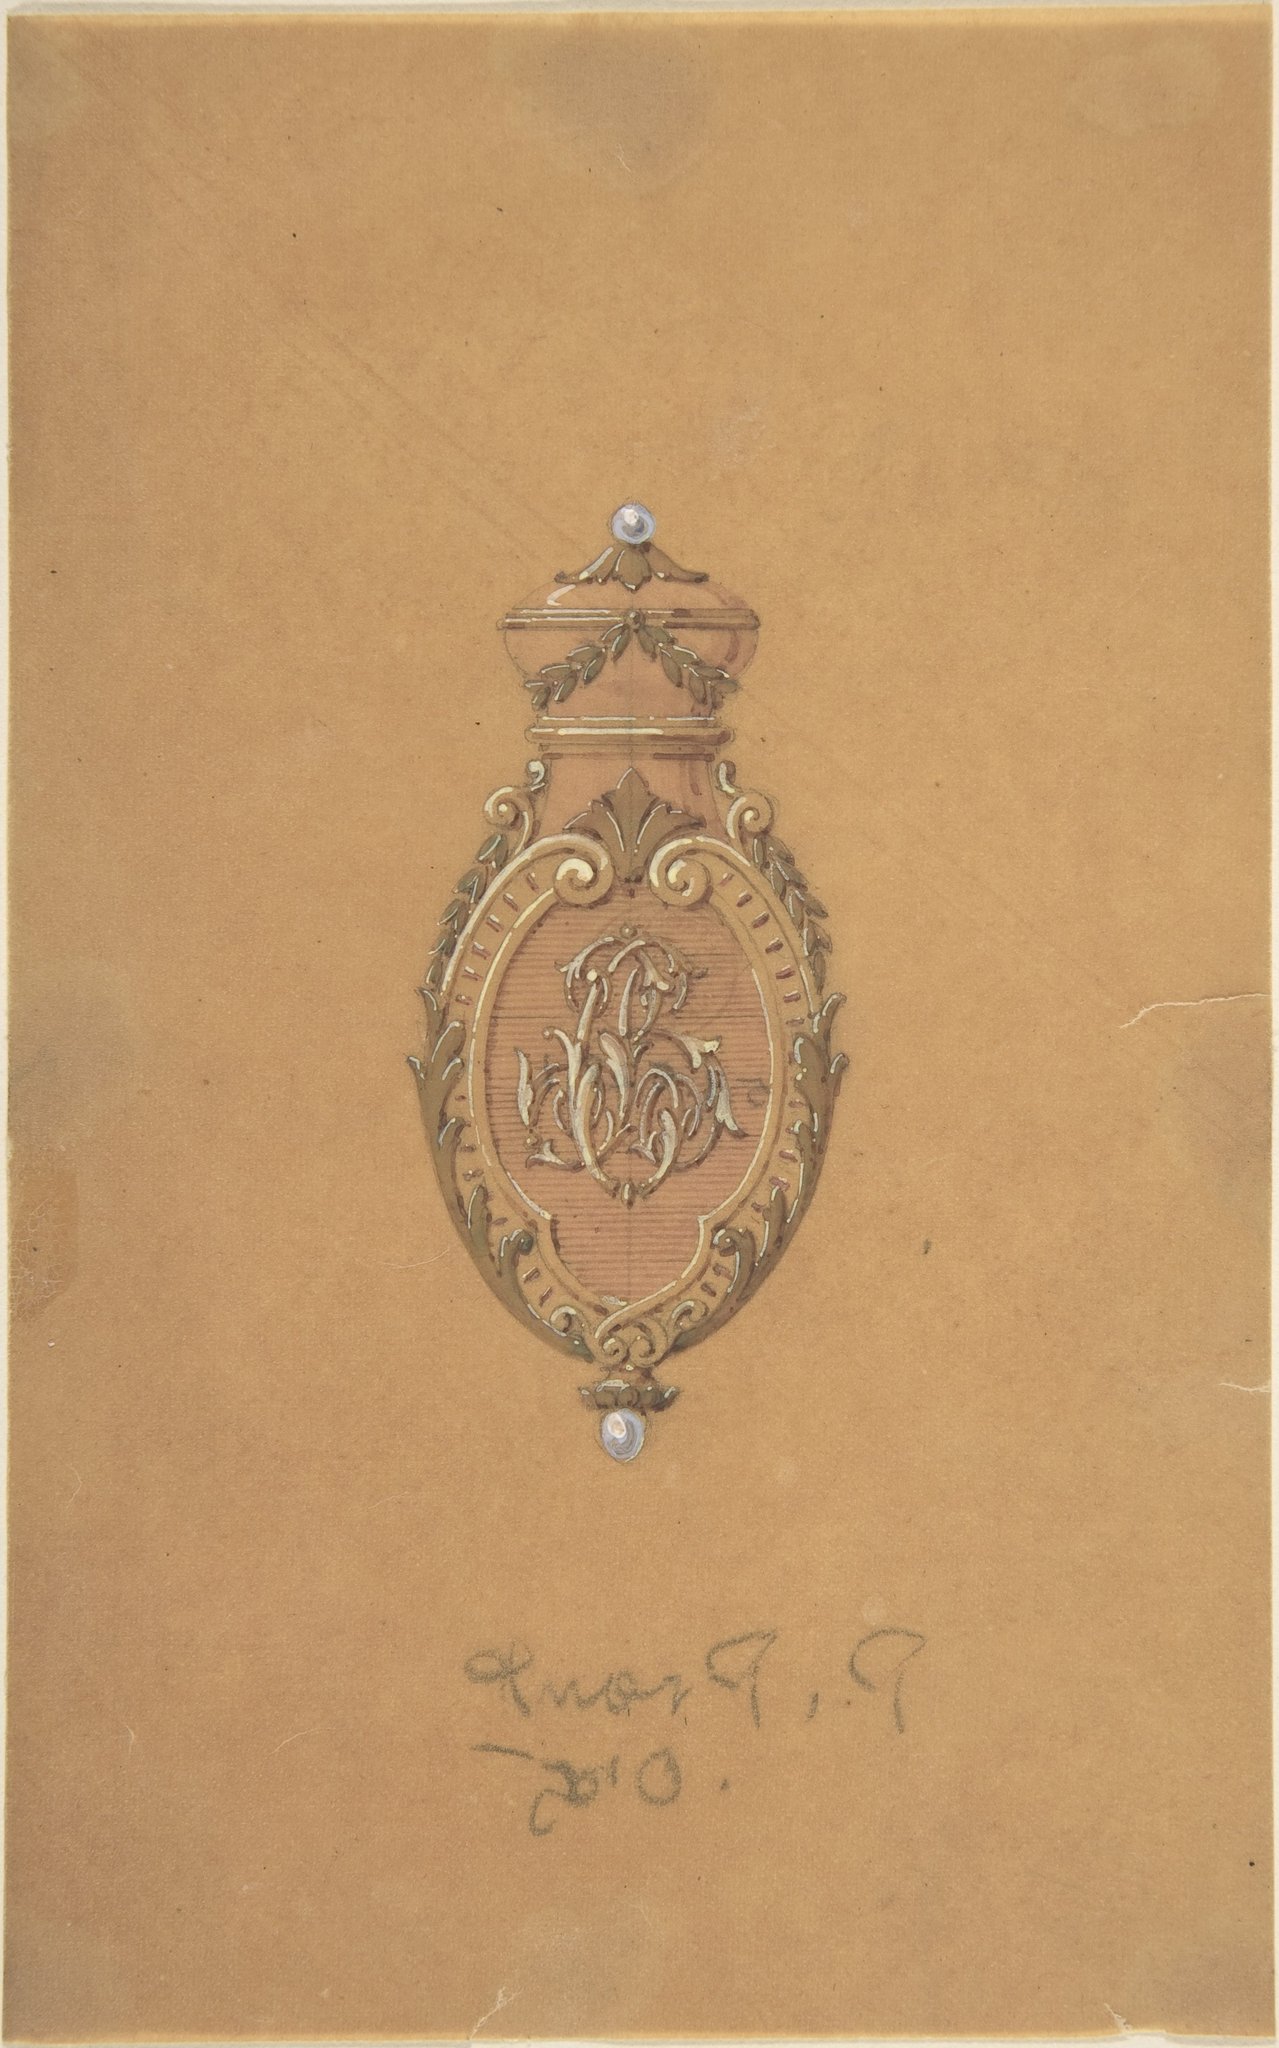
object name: drawing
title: Design for Jewelry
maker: anonymous, french, 19th century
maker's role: artist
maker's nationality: french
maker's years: 1800-1900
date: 1801-1900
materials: gouache, graphite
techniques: brush, wash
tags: jewelry